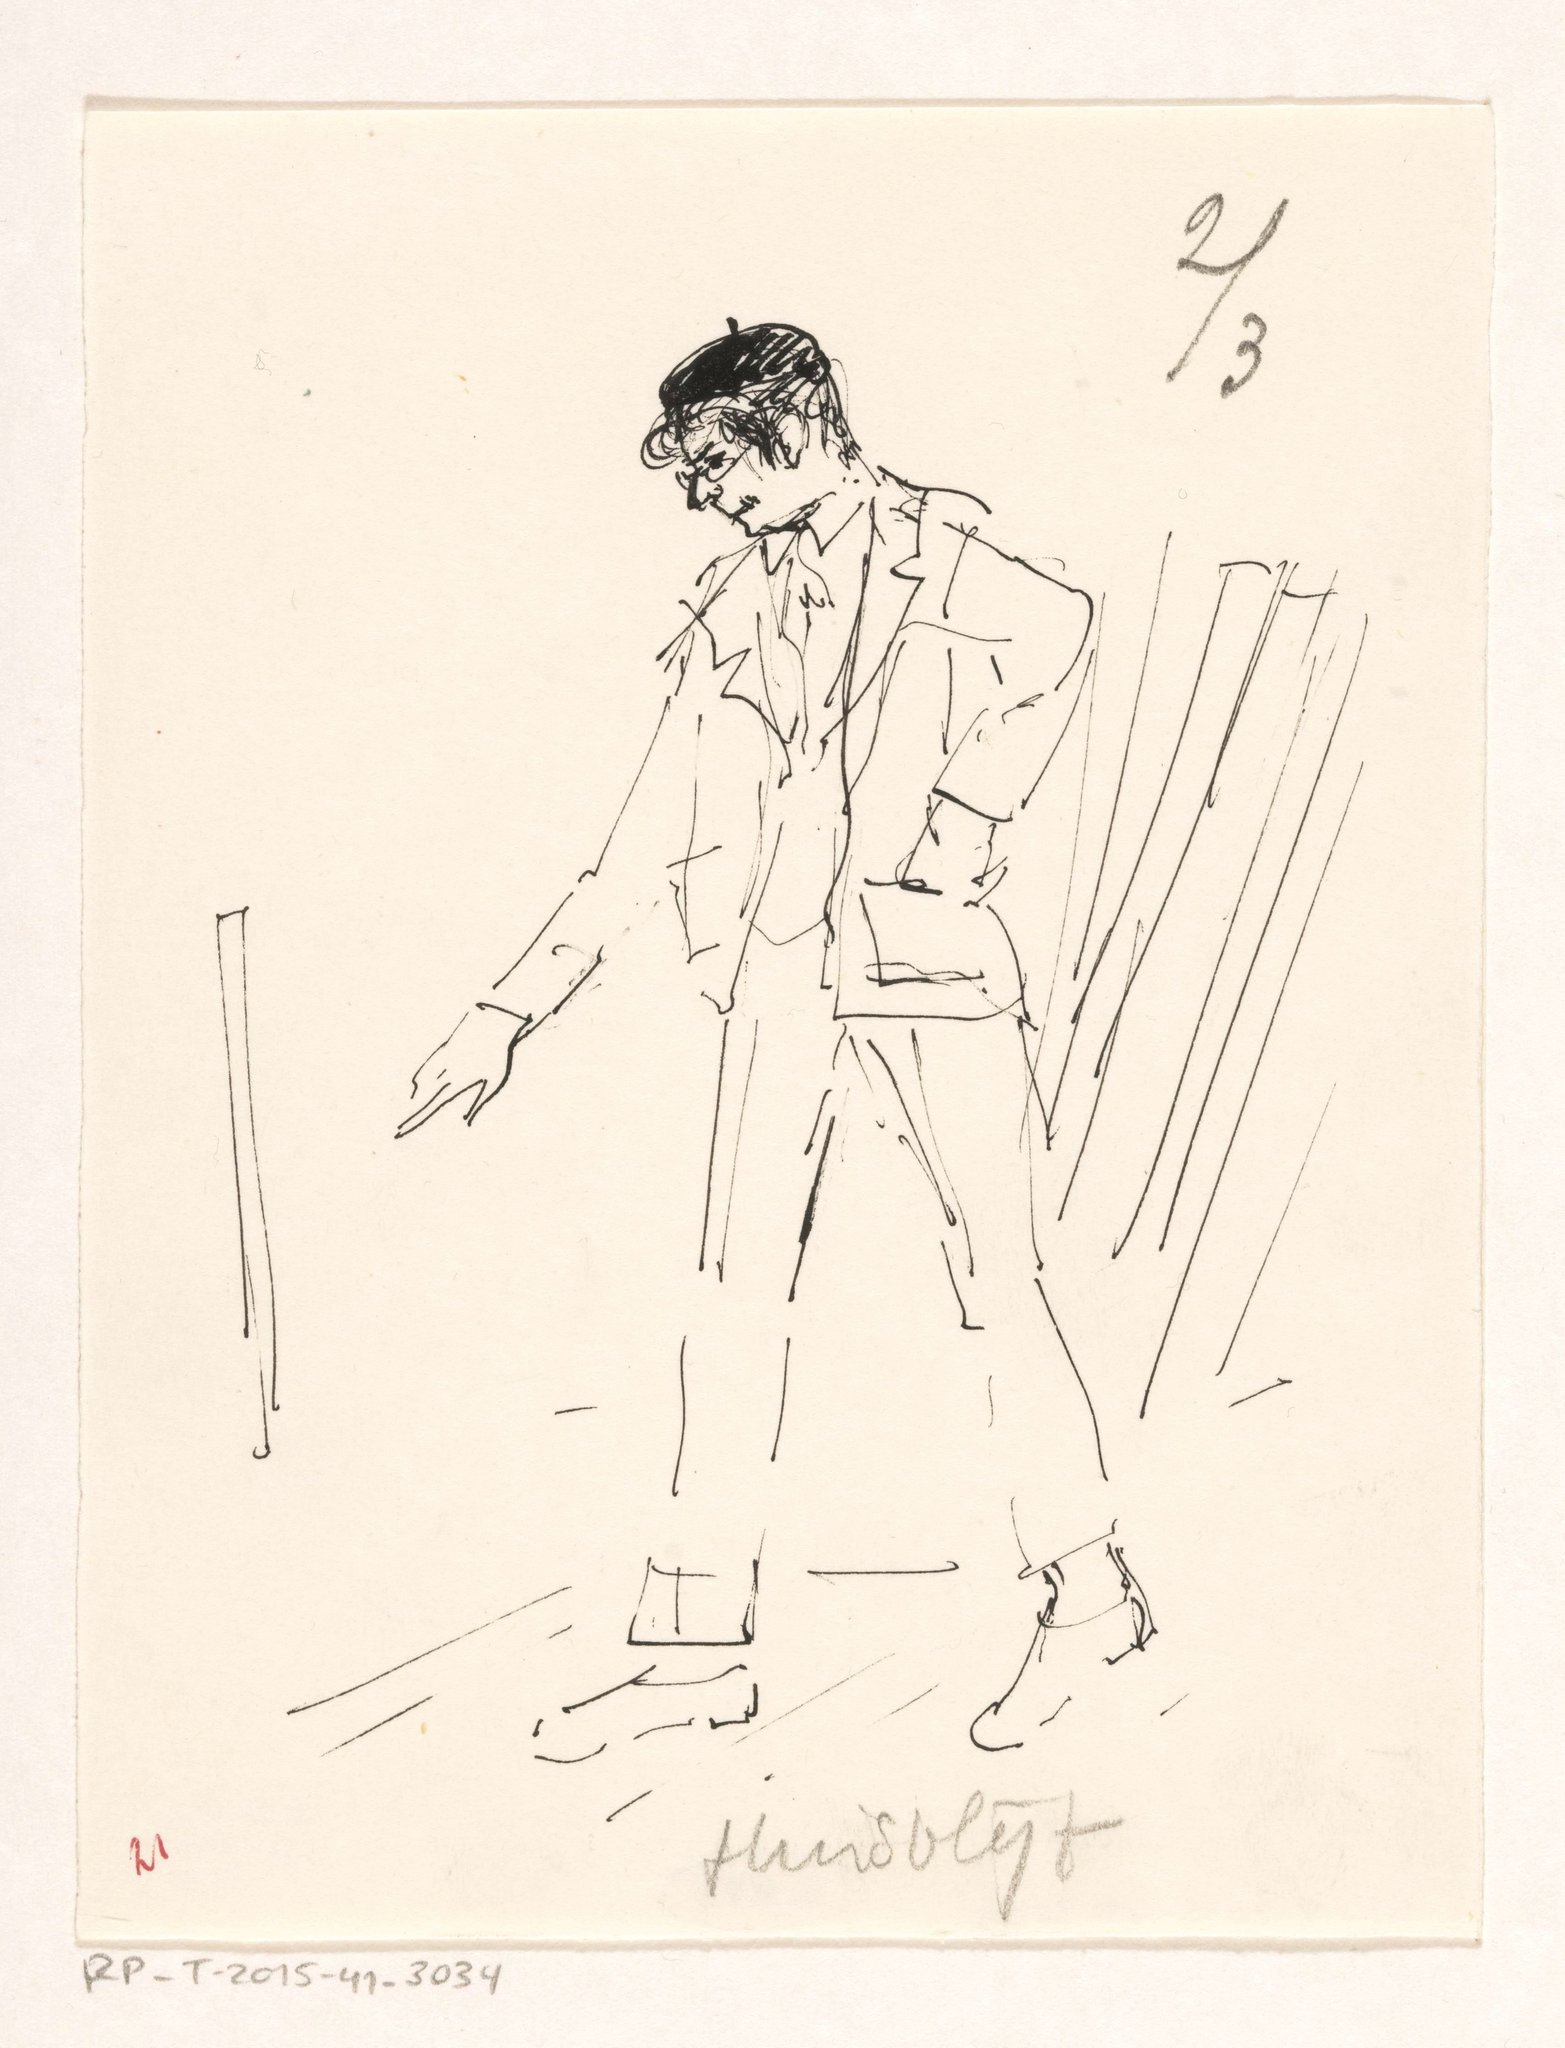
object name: boekillustratie ontwerp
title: Man wijst naar een muur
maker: Anonymous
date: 1930-1970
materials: ink, paper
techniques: pen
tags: index finger forwards, pointing, indicating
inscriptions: :, annotation: ‘Huisvlijt’, number: ‘21’, collector's mark: Lugt 2228a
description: Een man wijst naar een muur waar mogelijk een lat of plank aan is bevestigd. Achter hem staan meer latten of planken tegen de muur.